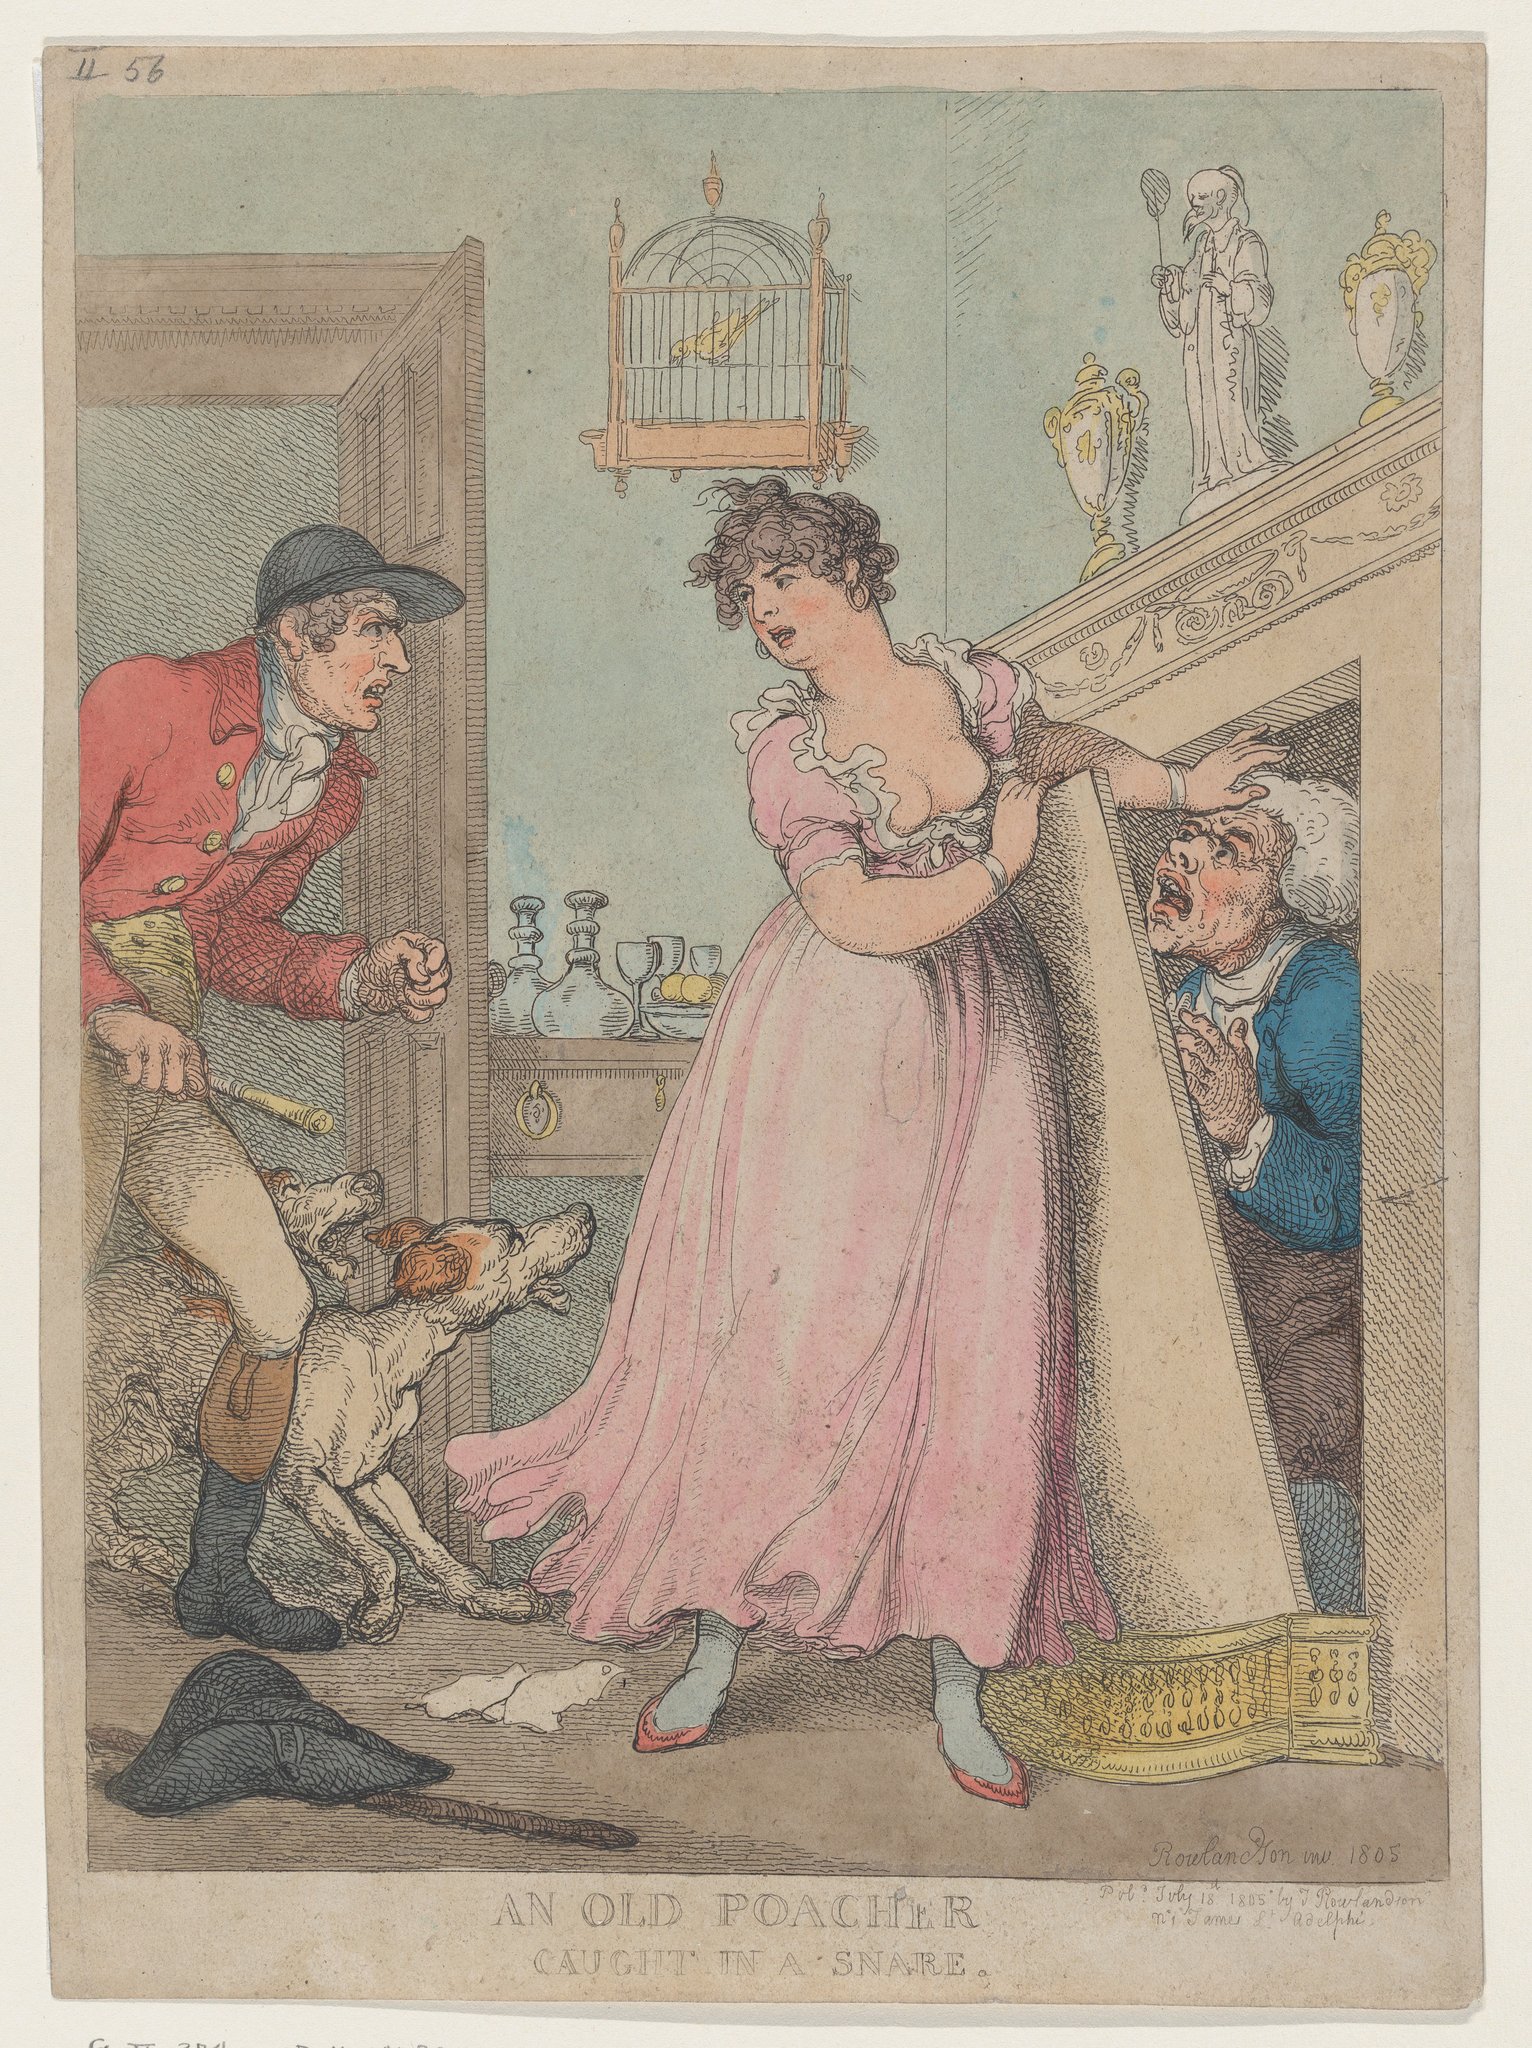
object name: print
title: An Old Poacher Caught in a Snare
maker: thomas rowlandson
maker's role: artist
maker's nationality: british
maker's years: 1757-1827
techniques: etching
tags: satire,men,women,dogs